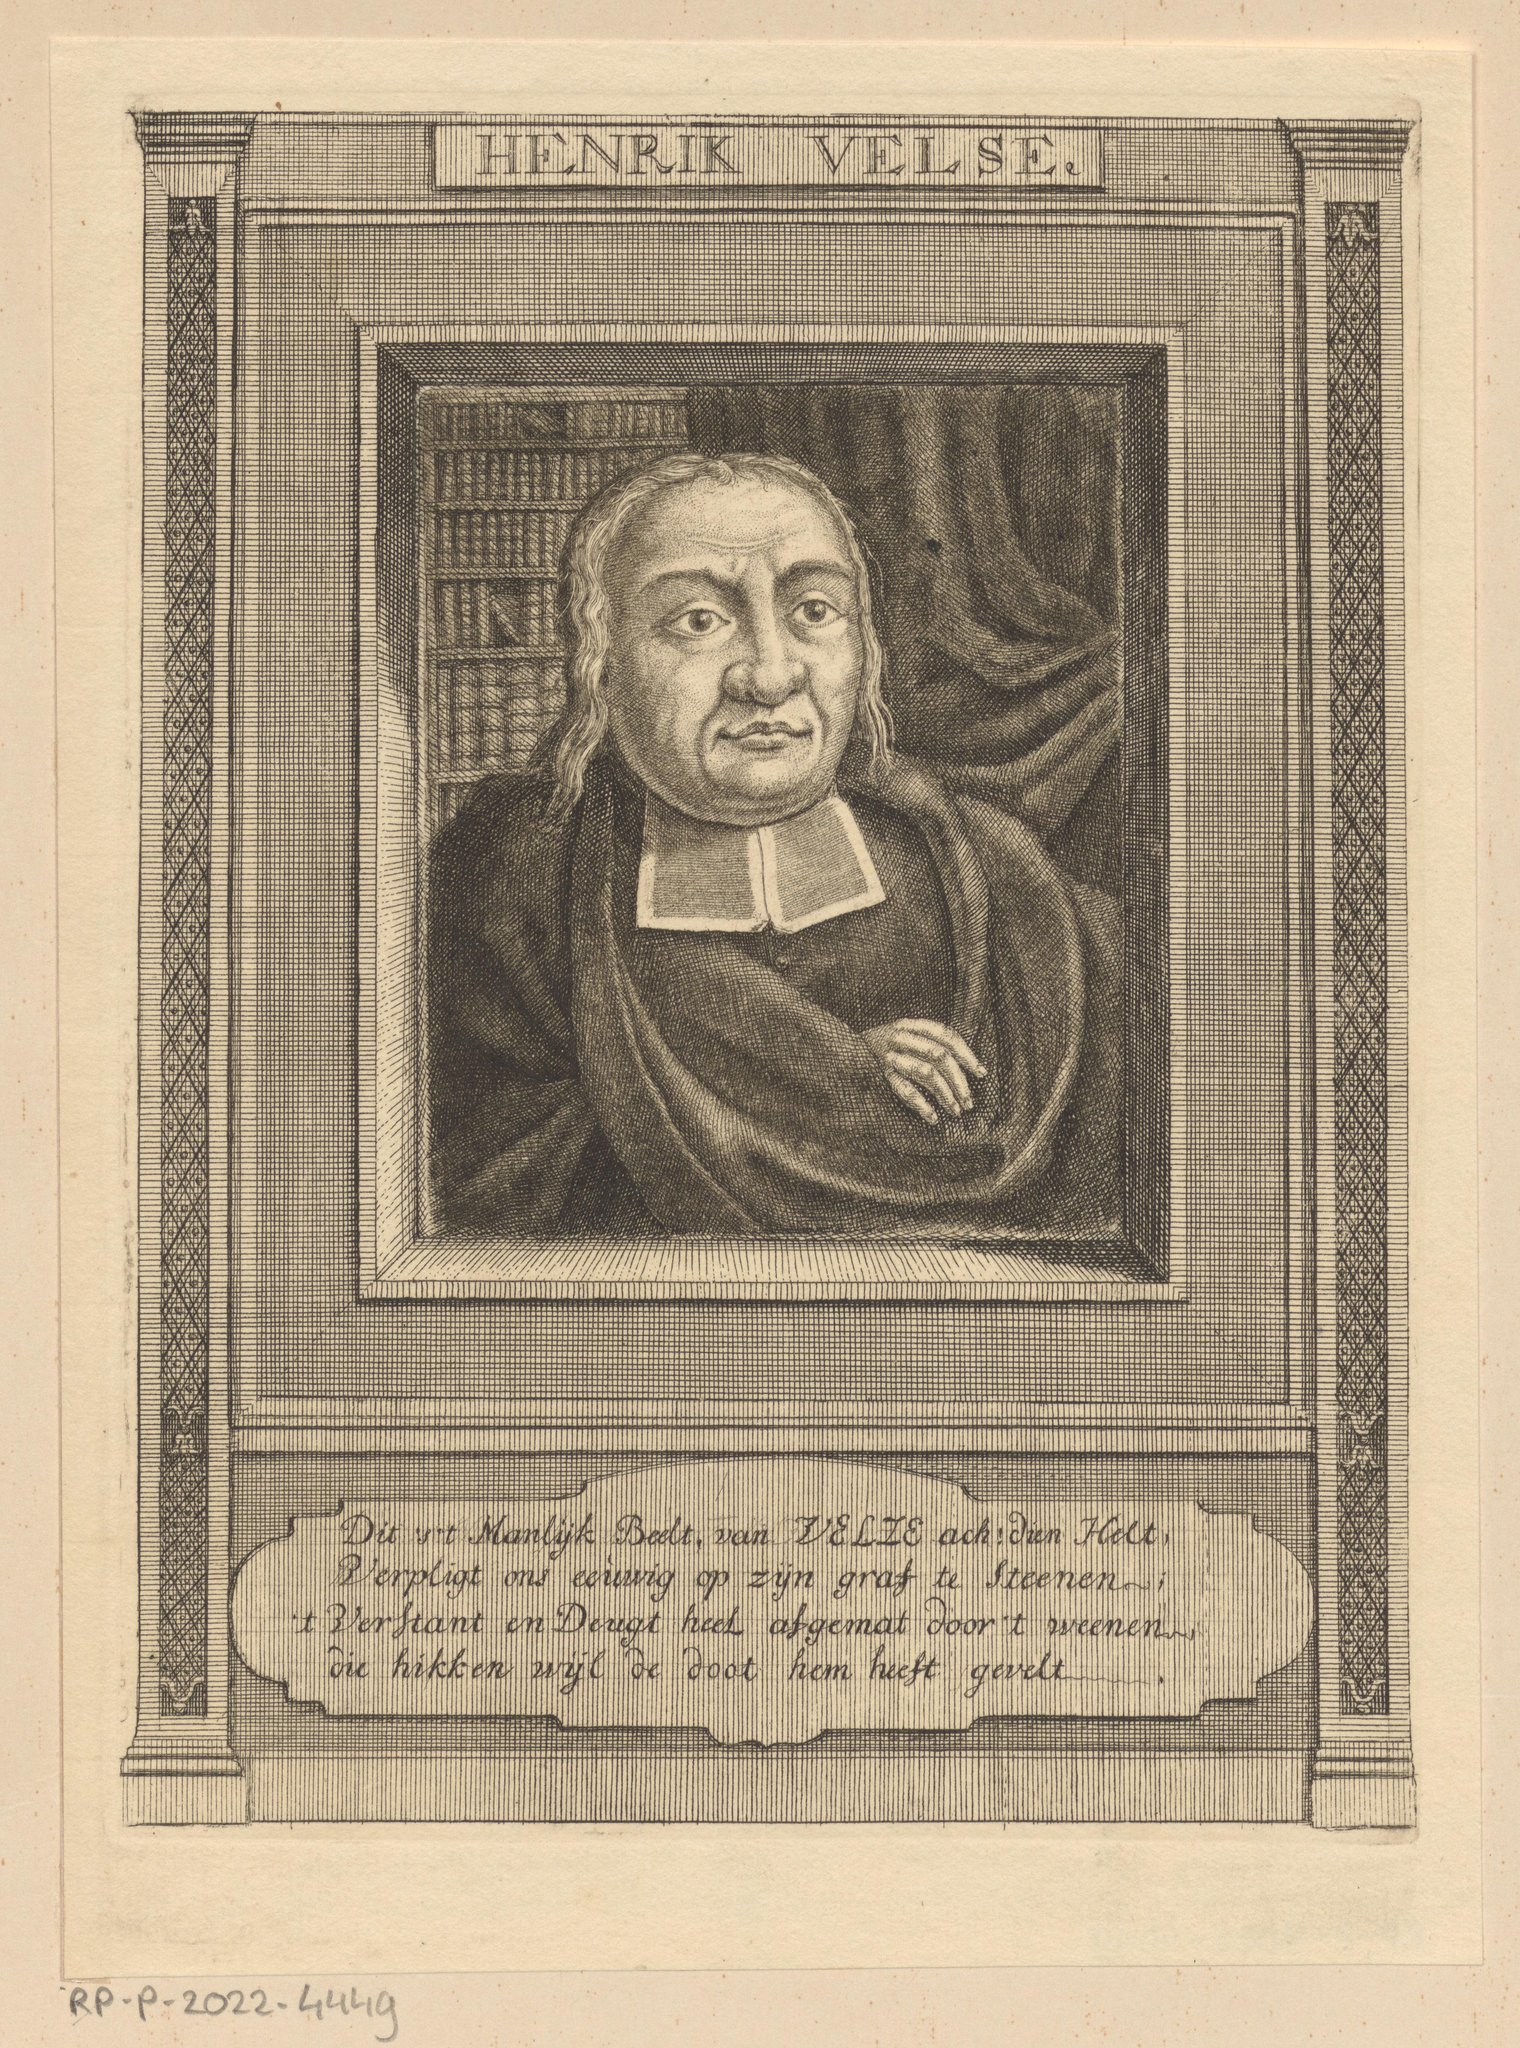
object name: print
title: Portret van Henricus Velse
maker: Anonymous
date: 1744-1799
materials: paper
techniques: engraving, etching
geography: northern netherlands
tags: the hague, functionaries and dignitaries (with name) ~ protestant churches, historical persons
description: Onder het portret een vierregelig vers in het Nederlands.